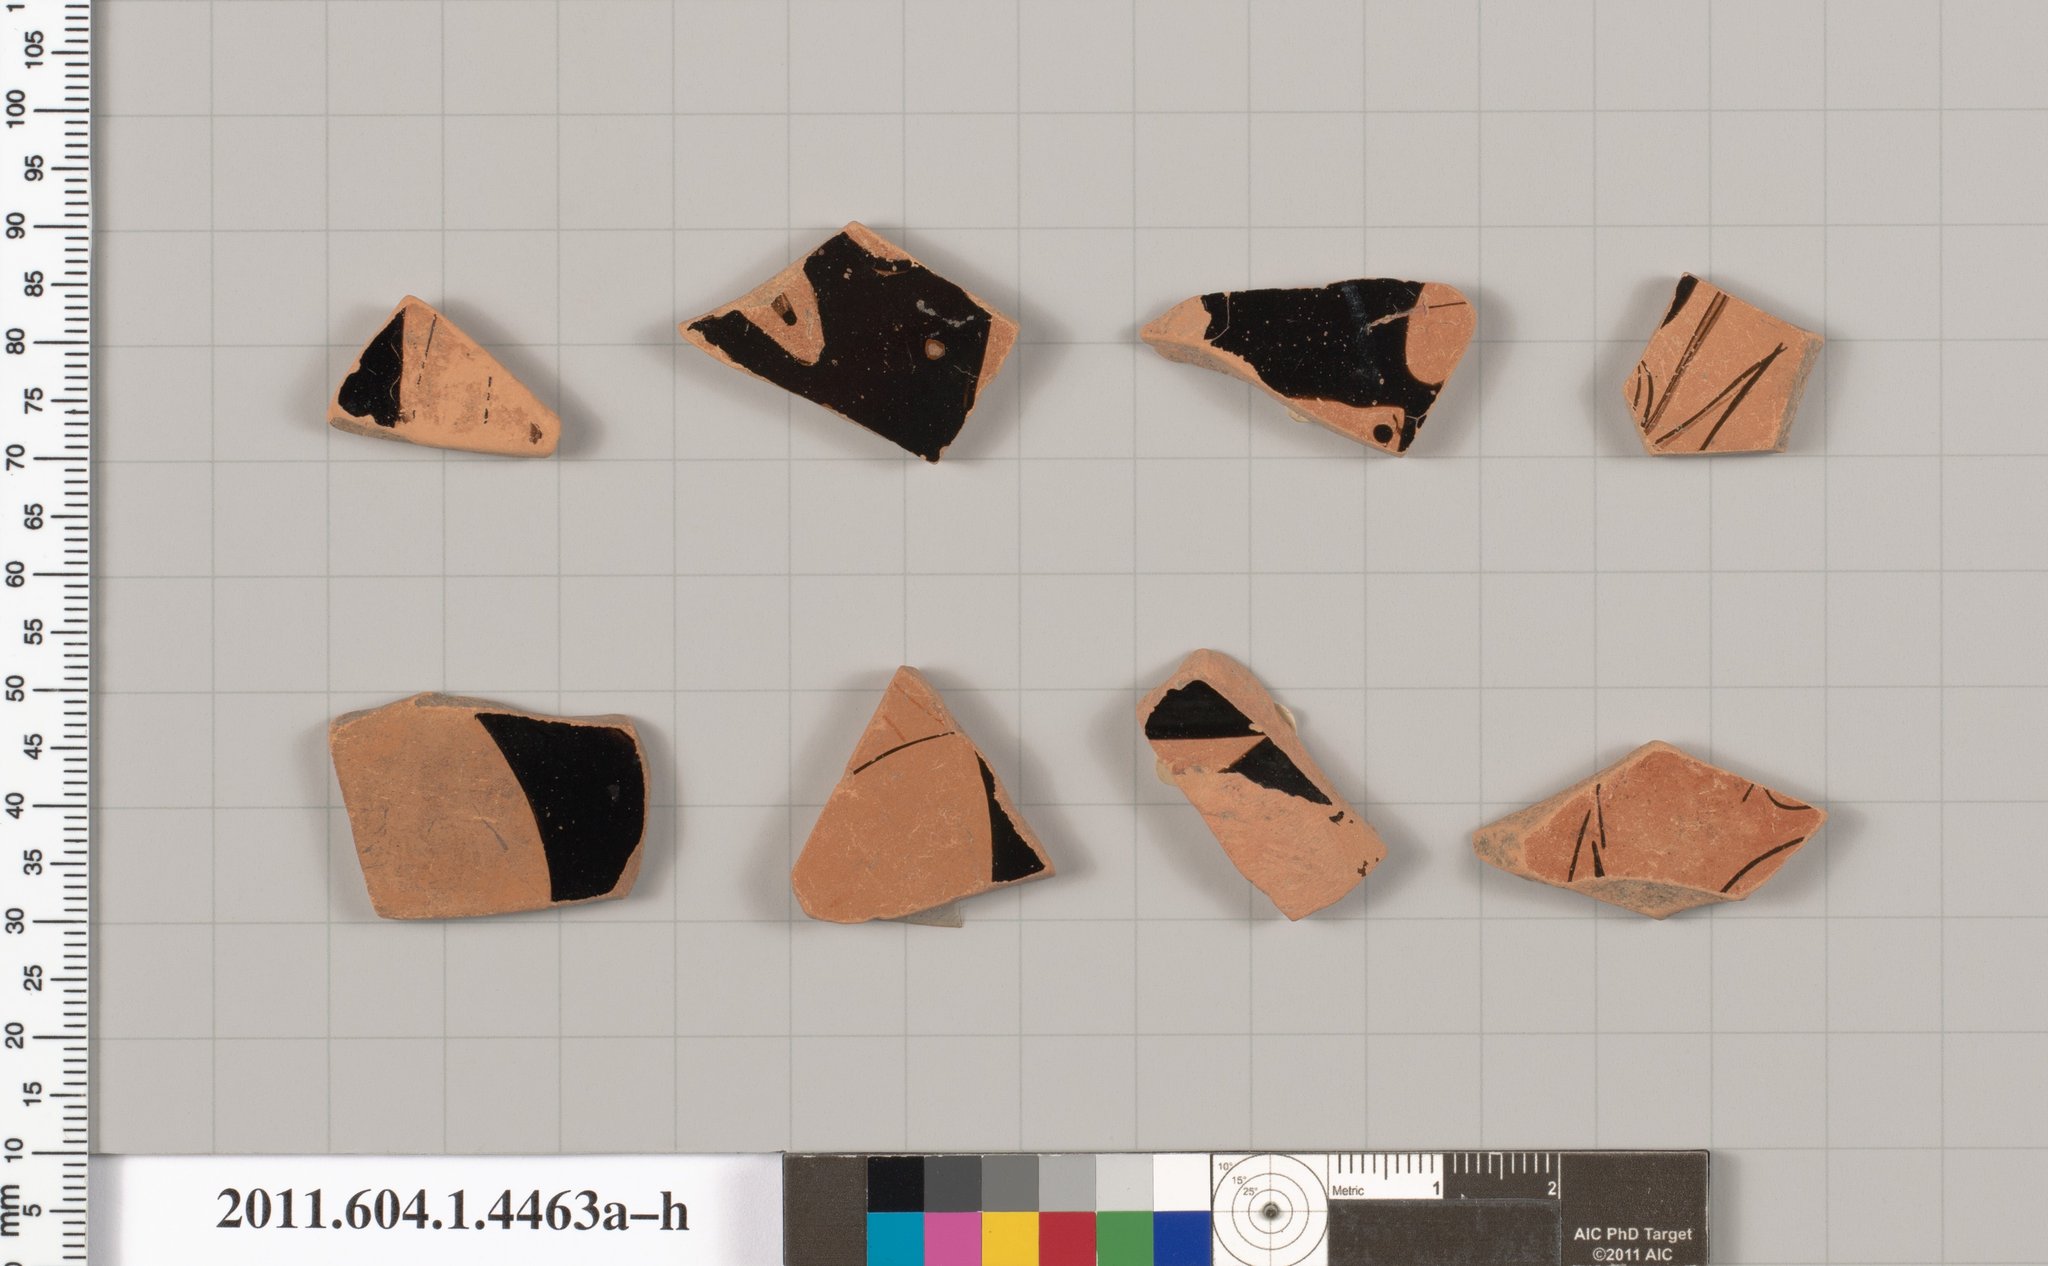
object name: kylix fragment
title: Terracotta fragments of kylikes (drinking cups)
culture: greek, attic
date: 500-451 BCE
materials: terracotta